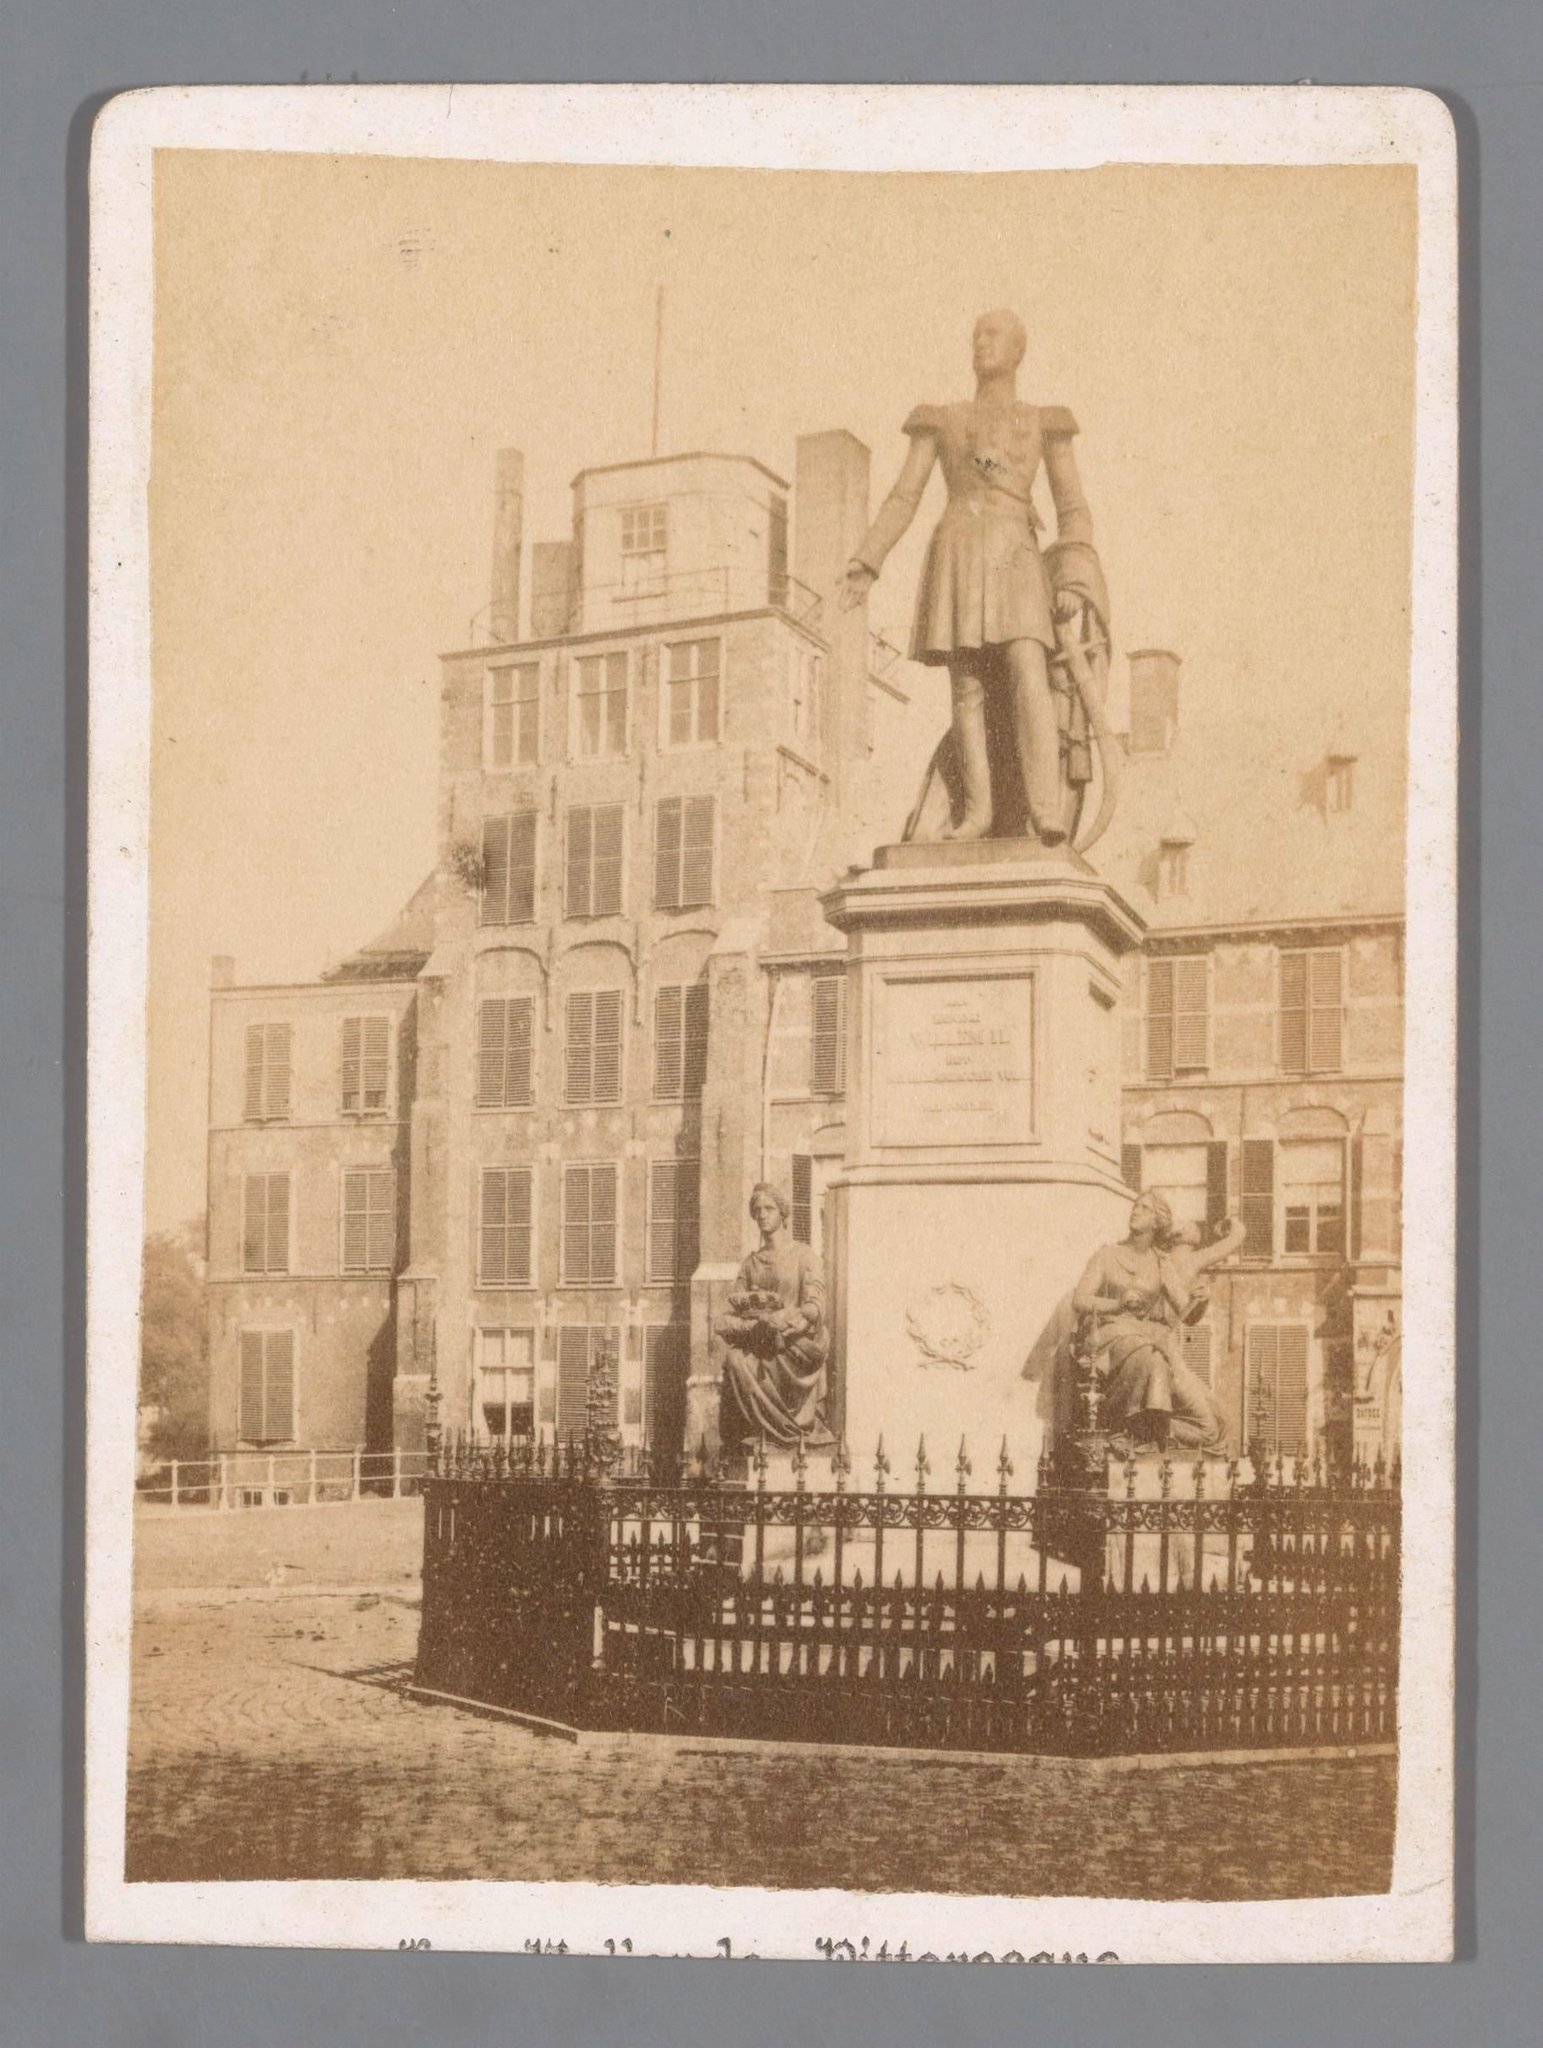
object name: photograph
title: Standbeeld van Willem II door E.F. Georges op het Buitenhof in Den Haag, met op de achtergrond het Binnenhof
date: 1854-1900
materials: cardboard, photographic support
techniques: albumen print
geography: france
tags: the hague, william ii of the netherlands, monument, statue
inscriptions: annotation: ‘Den Haag’, number: ‘20,-’, inscription: ‘[...] Hollande Pittoresque’, inscription: ‘COLLECTIONS STÉRÉOSCOPIQUES/ COMPLETES/ DE FRANCE, BELGIQUE,/ HOLLANDE, LONDRES,/ BORDS DU RHIN, ETC./ QUÉVAL, EDITEUR/ 22bis Rue Chaptal/ PARIS.’